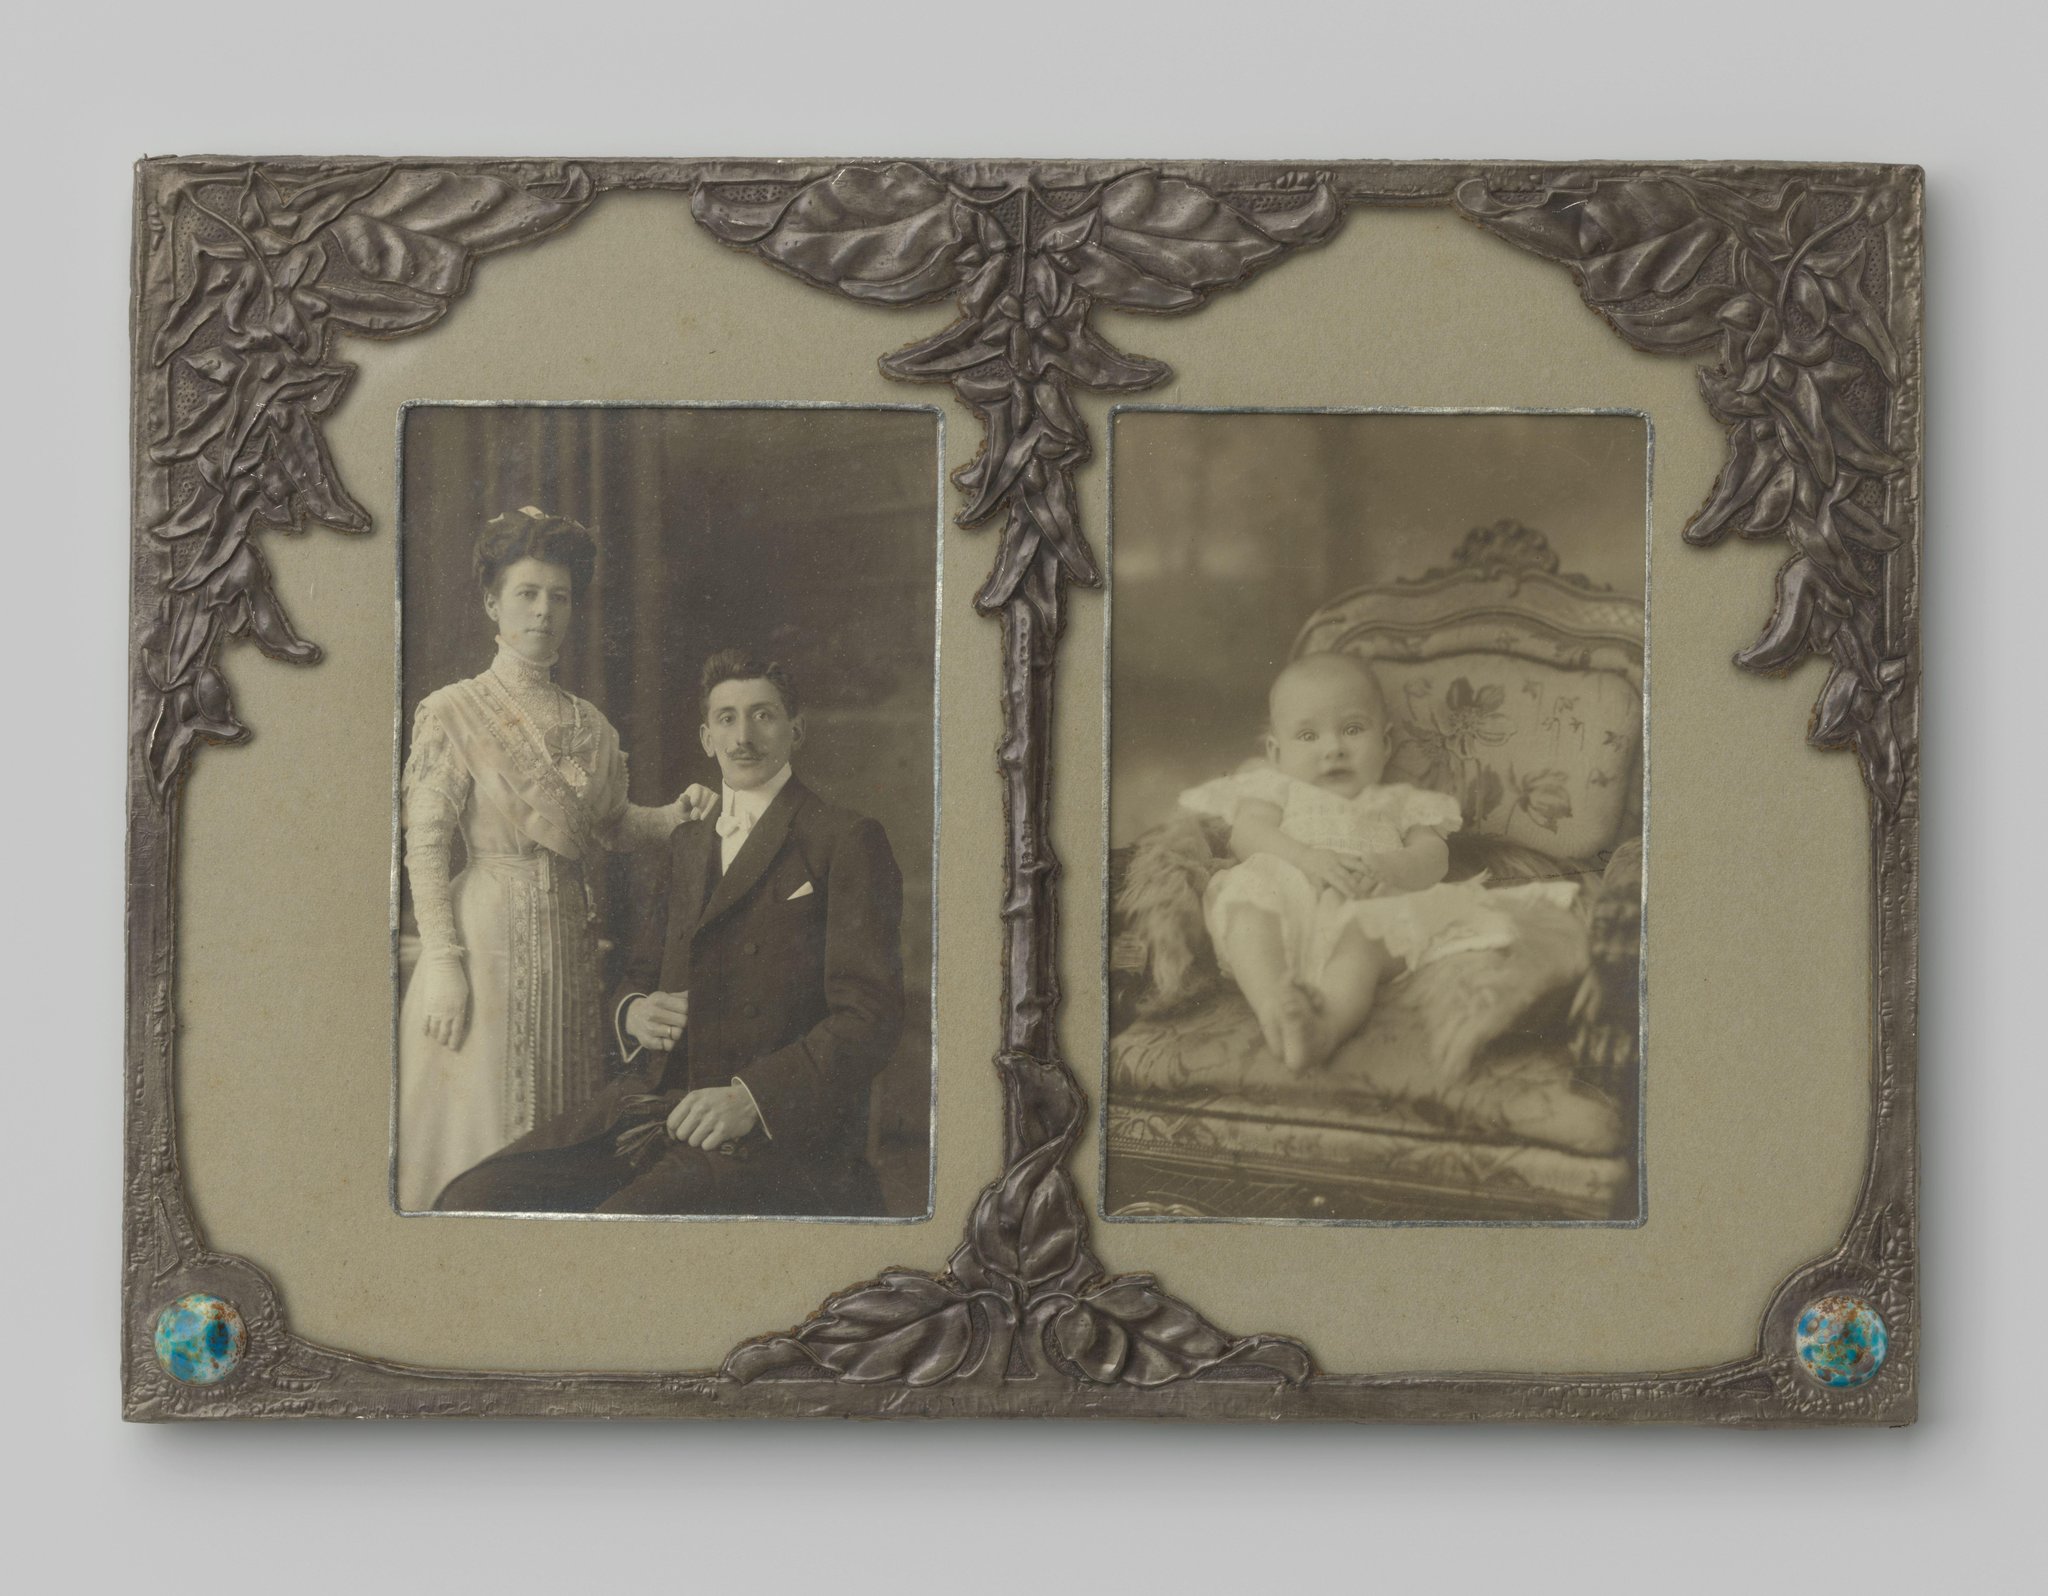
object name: cabinet photograph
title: Portret van een onbekende baby liggend op een stoel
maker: gerrit leenheer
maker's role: fotograaf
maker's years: 1874-1940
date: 1900-1915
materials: paper, cardboard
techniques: gelatin silver print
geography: amsterdam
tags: anonymous historical person portrayed, infant, baby ~ the ages of man